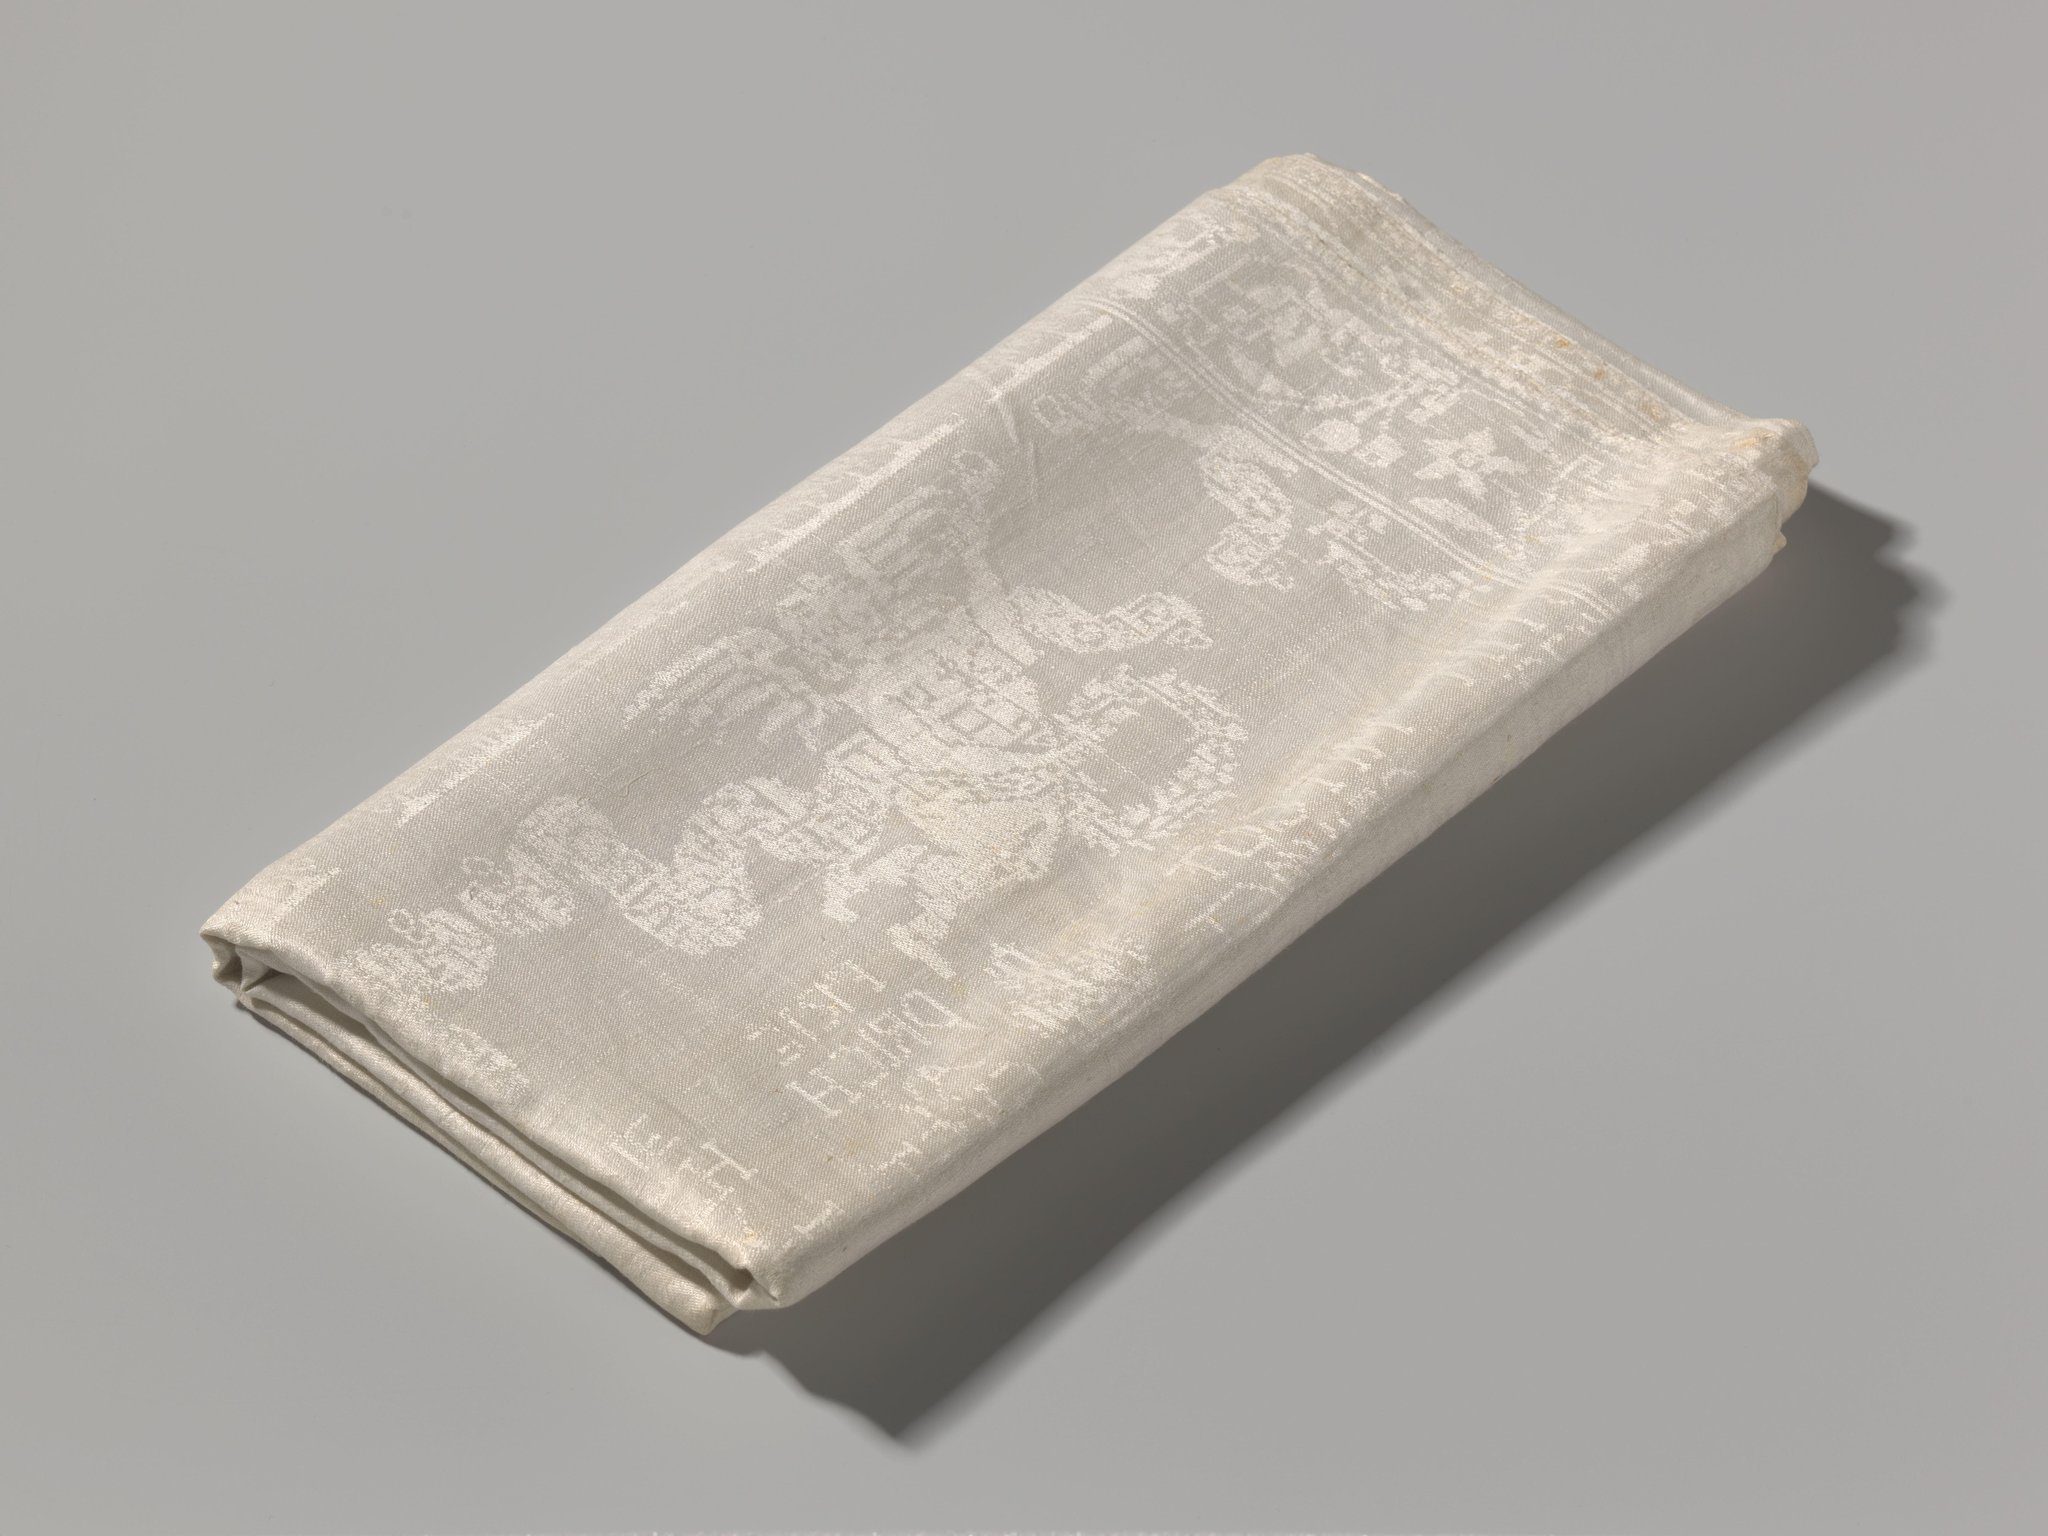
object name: tablecloth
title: Tafellaken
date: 1670-1700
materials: linen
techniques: damask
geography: germany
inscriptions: mark: ‘Burrough’, mark: ‘RMR’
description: Wit linnen damasten tafellaken met een gezicht op Krakau, met inweving "CRACAVW" en "MIT GOT GEWAGT VND VNVERZAGT" en "FRIEDRICH AVGVST", gemerkt RMR en Burrough.